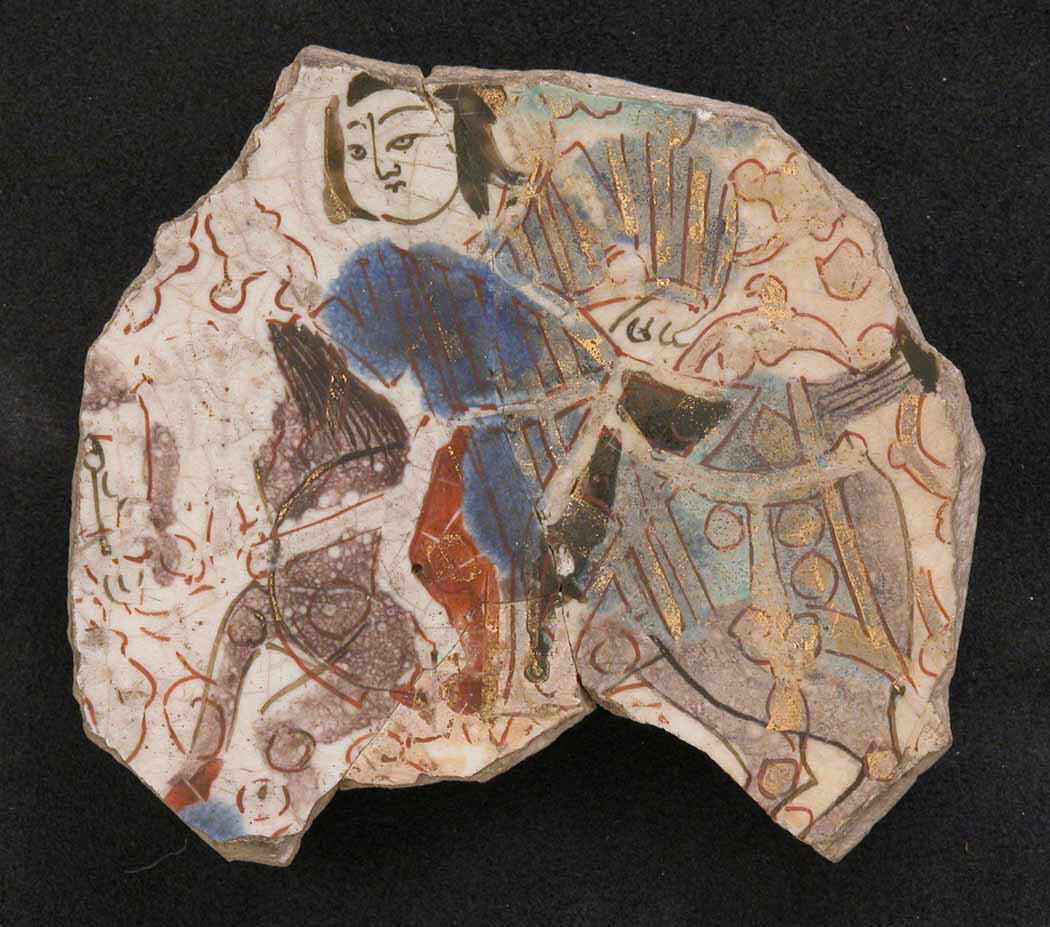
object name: fragment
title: Fragment of a Bowl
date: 1101-1300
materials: stonepaste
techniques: overglaze, painting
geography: iran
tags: women